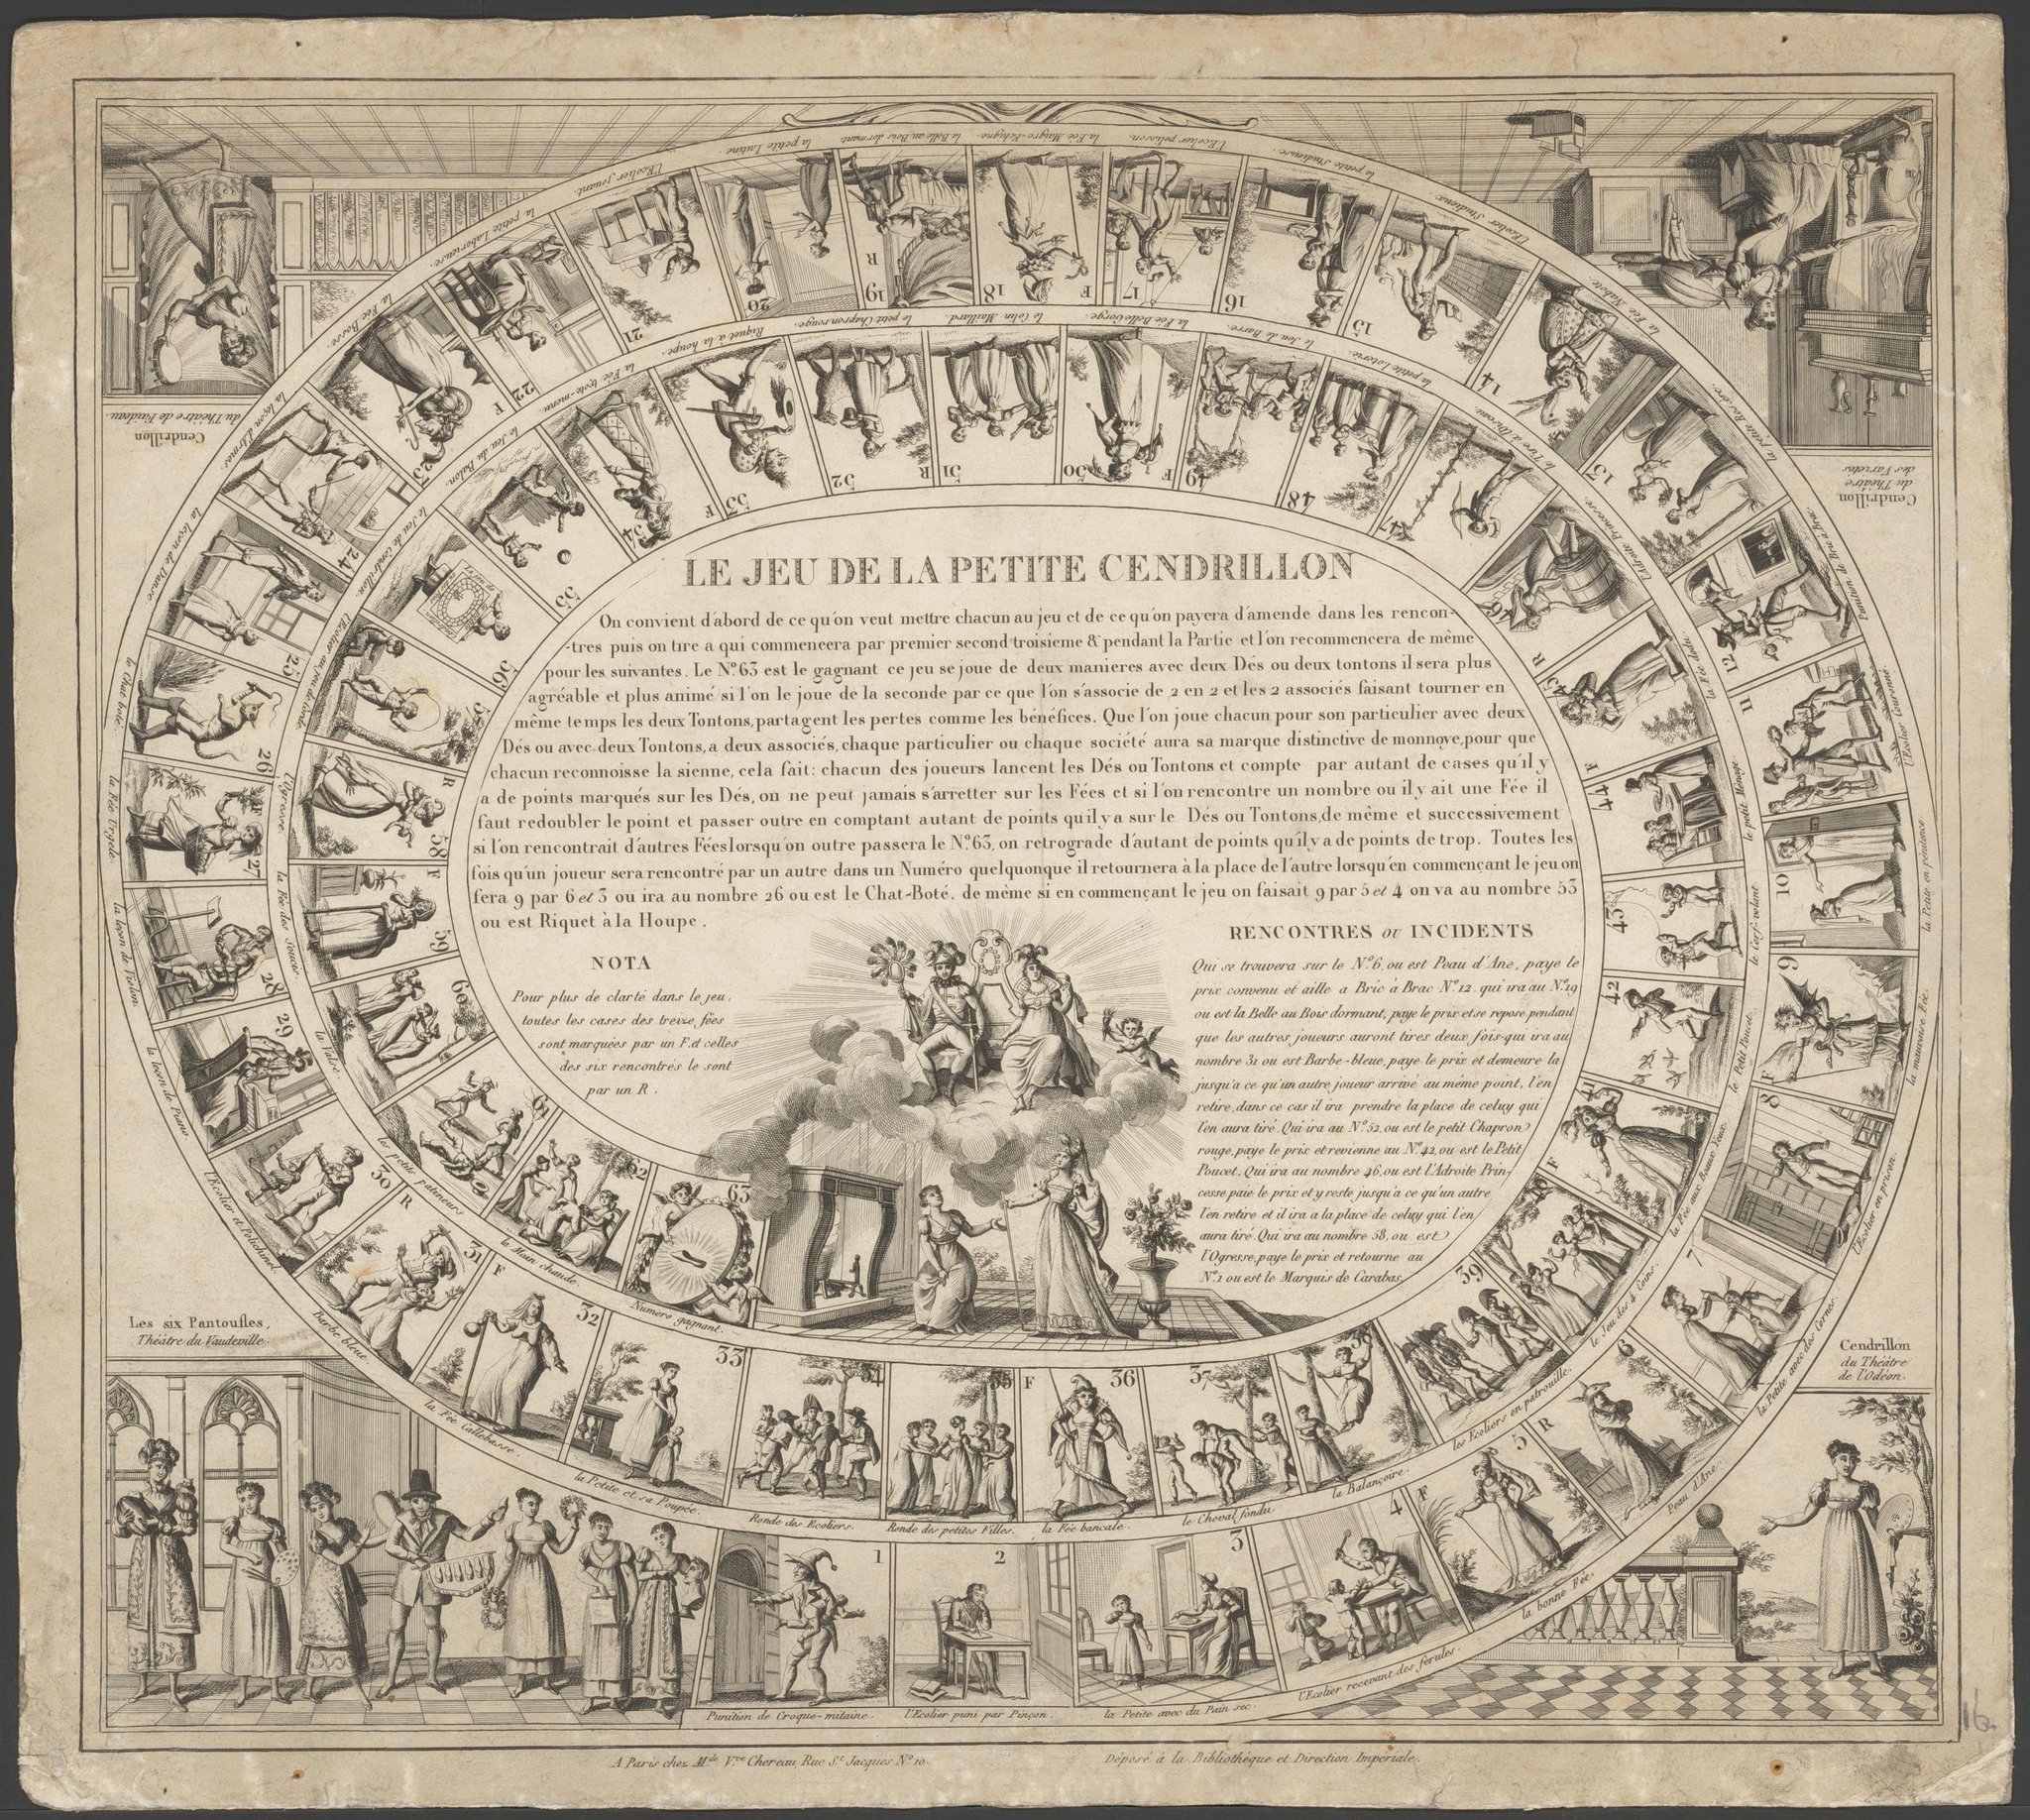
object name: print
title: Le Jeu de la Petite Cendrillon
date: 1812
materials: cardboard, paper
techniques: engraving, etching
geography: paris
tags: goose-game, theatre, theatrical performance, tales and fairy tales (with title)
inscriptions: collector's mark, collector's mark: Lugt 1641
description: Een werpspel met 63 vakjes rondom het sprookje van Assepoester. In het midden de spelregels. In de vakken afbeeldingen van zeer diverse aard waaronder sprookjesfiguren en kinderspelen. In de hoeken afbeeldingen van de scènes uit het toneelstuk zoals dat te Parijs vanaf 1810 werd opgevoerd: Les six Pantoufles, Théatre du Vaudeville. Cendrillon du Théatre de l'Odéon, Cendrillon du Théatre des Varietés, Cendrillon du Théatre de Faideau. Onderwerpsrubrieken binnen de Atlas Zeden en Gewoonten: Spel en Vermaak; gezelschapsspel, ganzenbord en dergelijke.